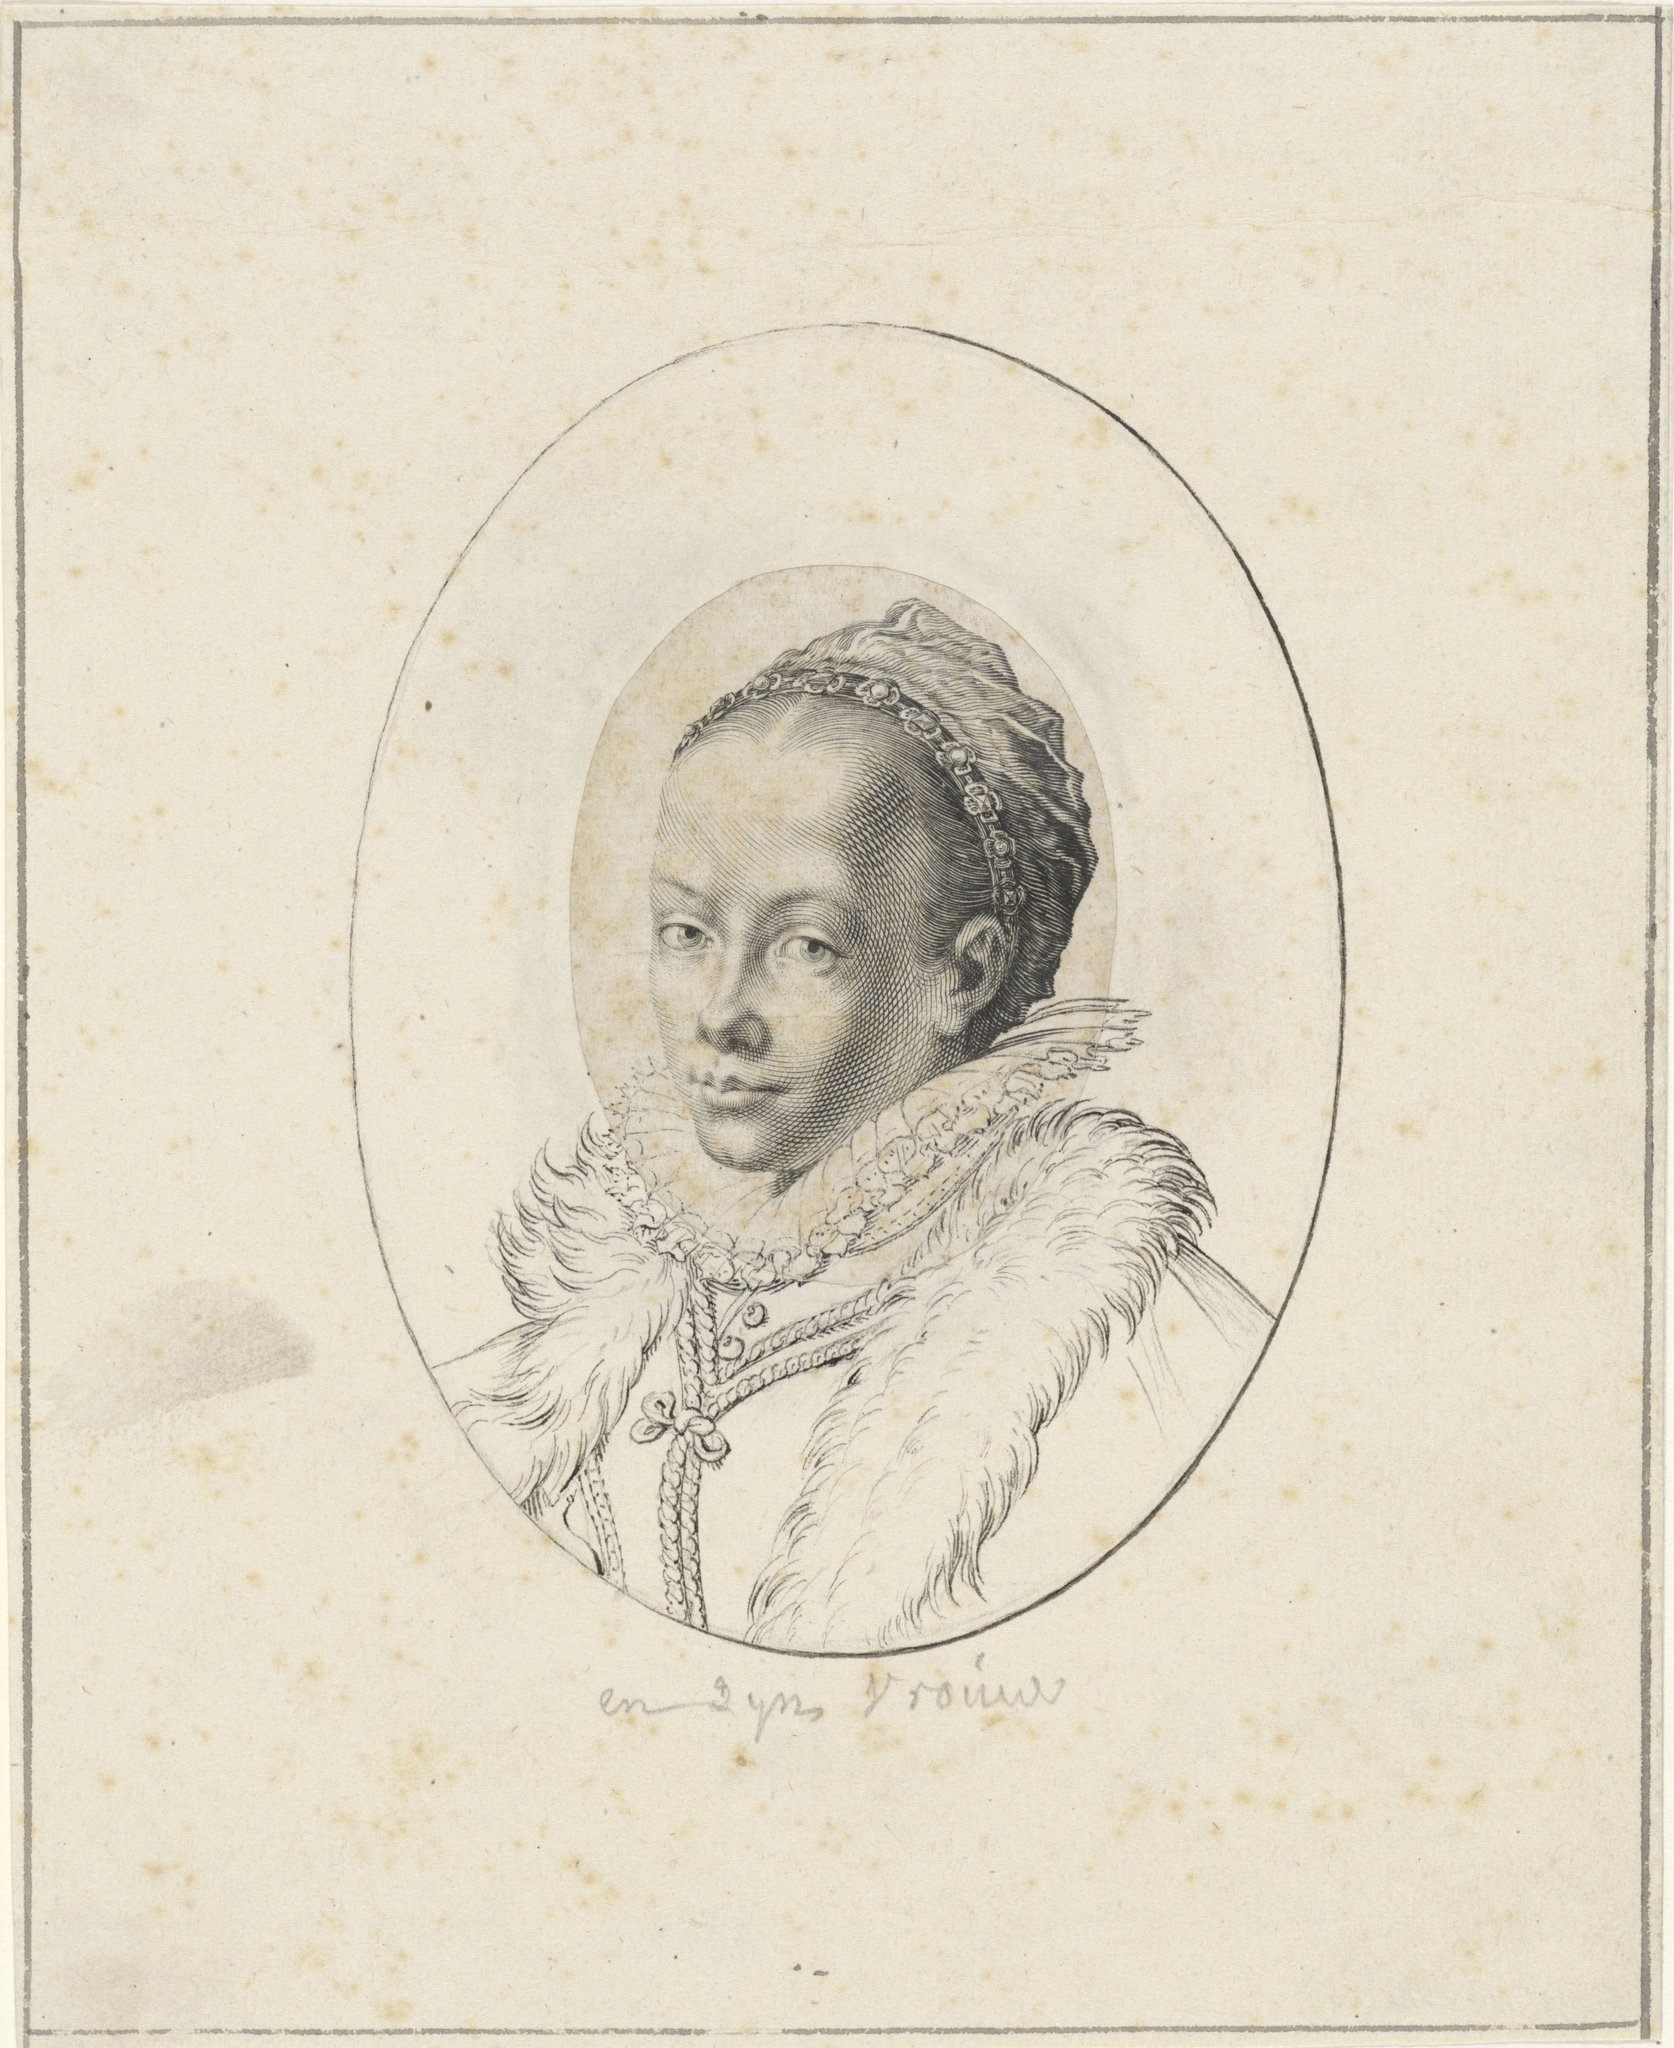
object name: drawing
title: Portret van Christina Muller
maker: aegidius sadeler (ii)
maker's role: draughtsman, print maker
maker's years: 1568-1629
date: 1600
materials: paper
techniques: engraving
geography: prague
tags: christina muller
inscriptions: collector's mark: Lugt 240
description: Gedenkprent voor Christina Muller, de overleden vrouw van de schilder Batholomeus Spranger. Het hoofd van de vrouw is uit een eerdere gravure van Sadeler geknipt.